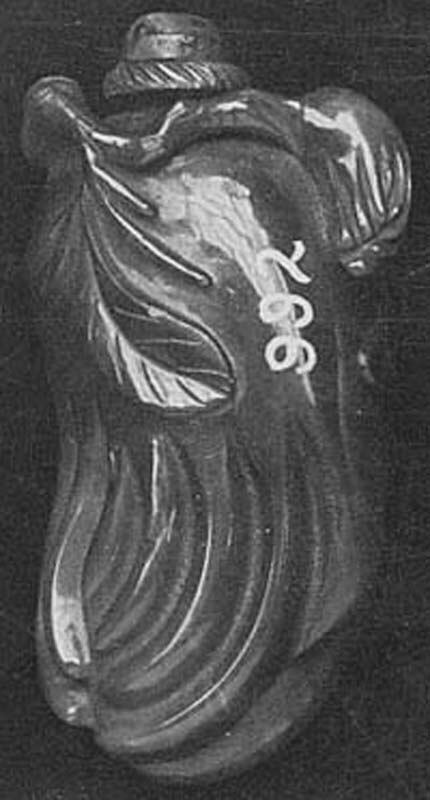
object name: snuff bottle with stopper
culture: chinese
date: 1701-1900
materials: stone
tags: leaves